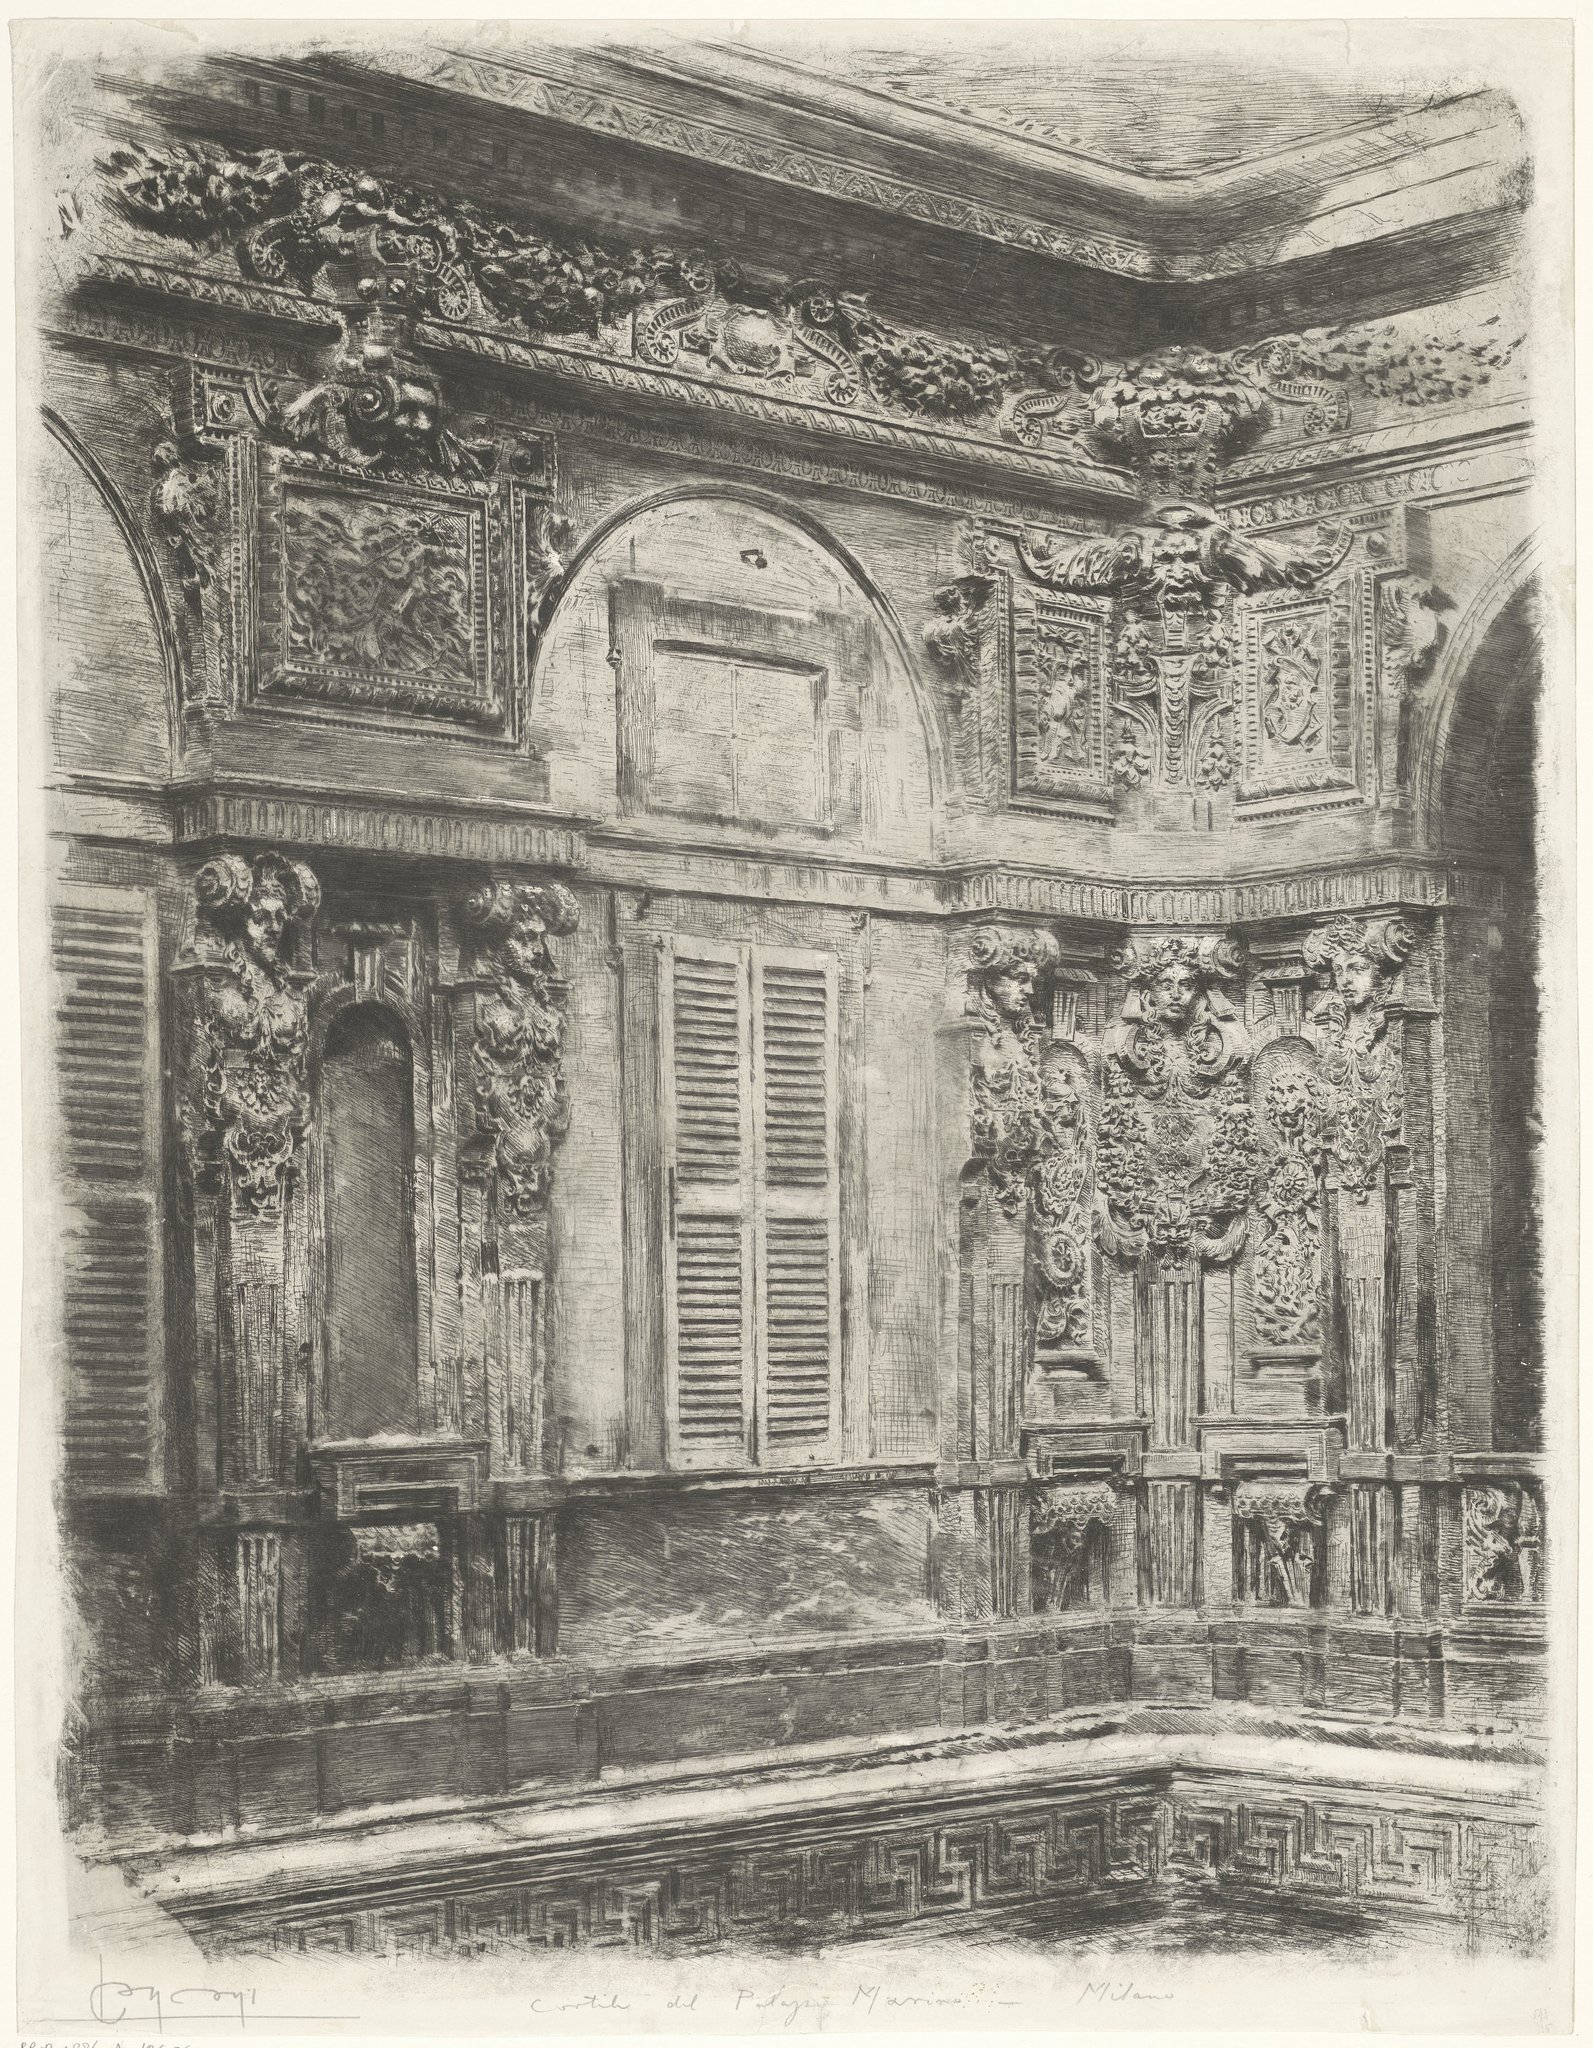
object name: print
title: Cortile del Palazzo Marino - Milano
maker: luigi conconi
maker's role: painter, print maker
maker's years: 1852-1917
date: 1862-1886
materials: paper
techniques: drypoint, etching, intaglio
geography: italy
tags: façade of inner court, inner court of palace or 'hôtel'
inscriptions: collector's mark: Lugt 2228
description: Een deel van de rijkelijk met beeldhouwwerk versierde gevel op de binnenplaats van het Palazzo Marino te Milaan.